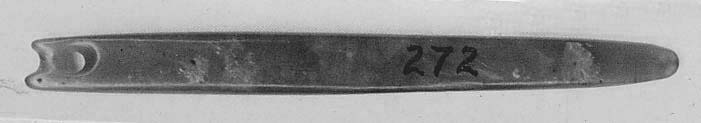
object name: knife sharpener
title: Knife-sharpener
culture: north american, alaskan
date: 1902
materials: jade